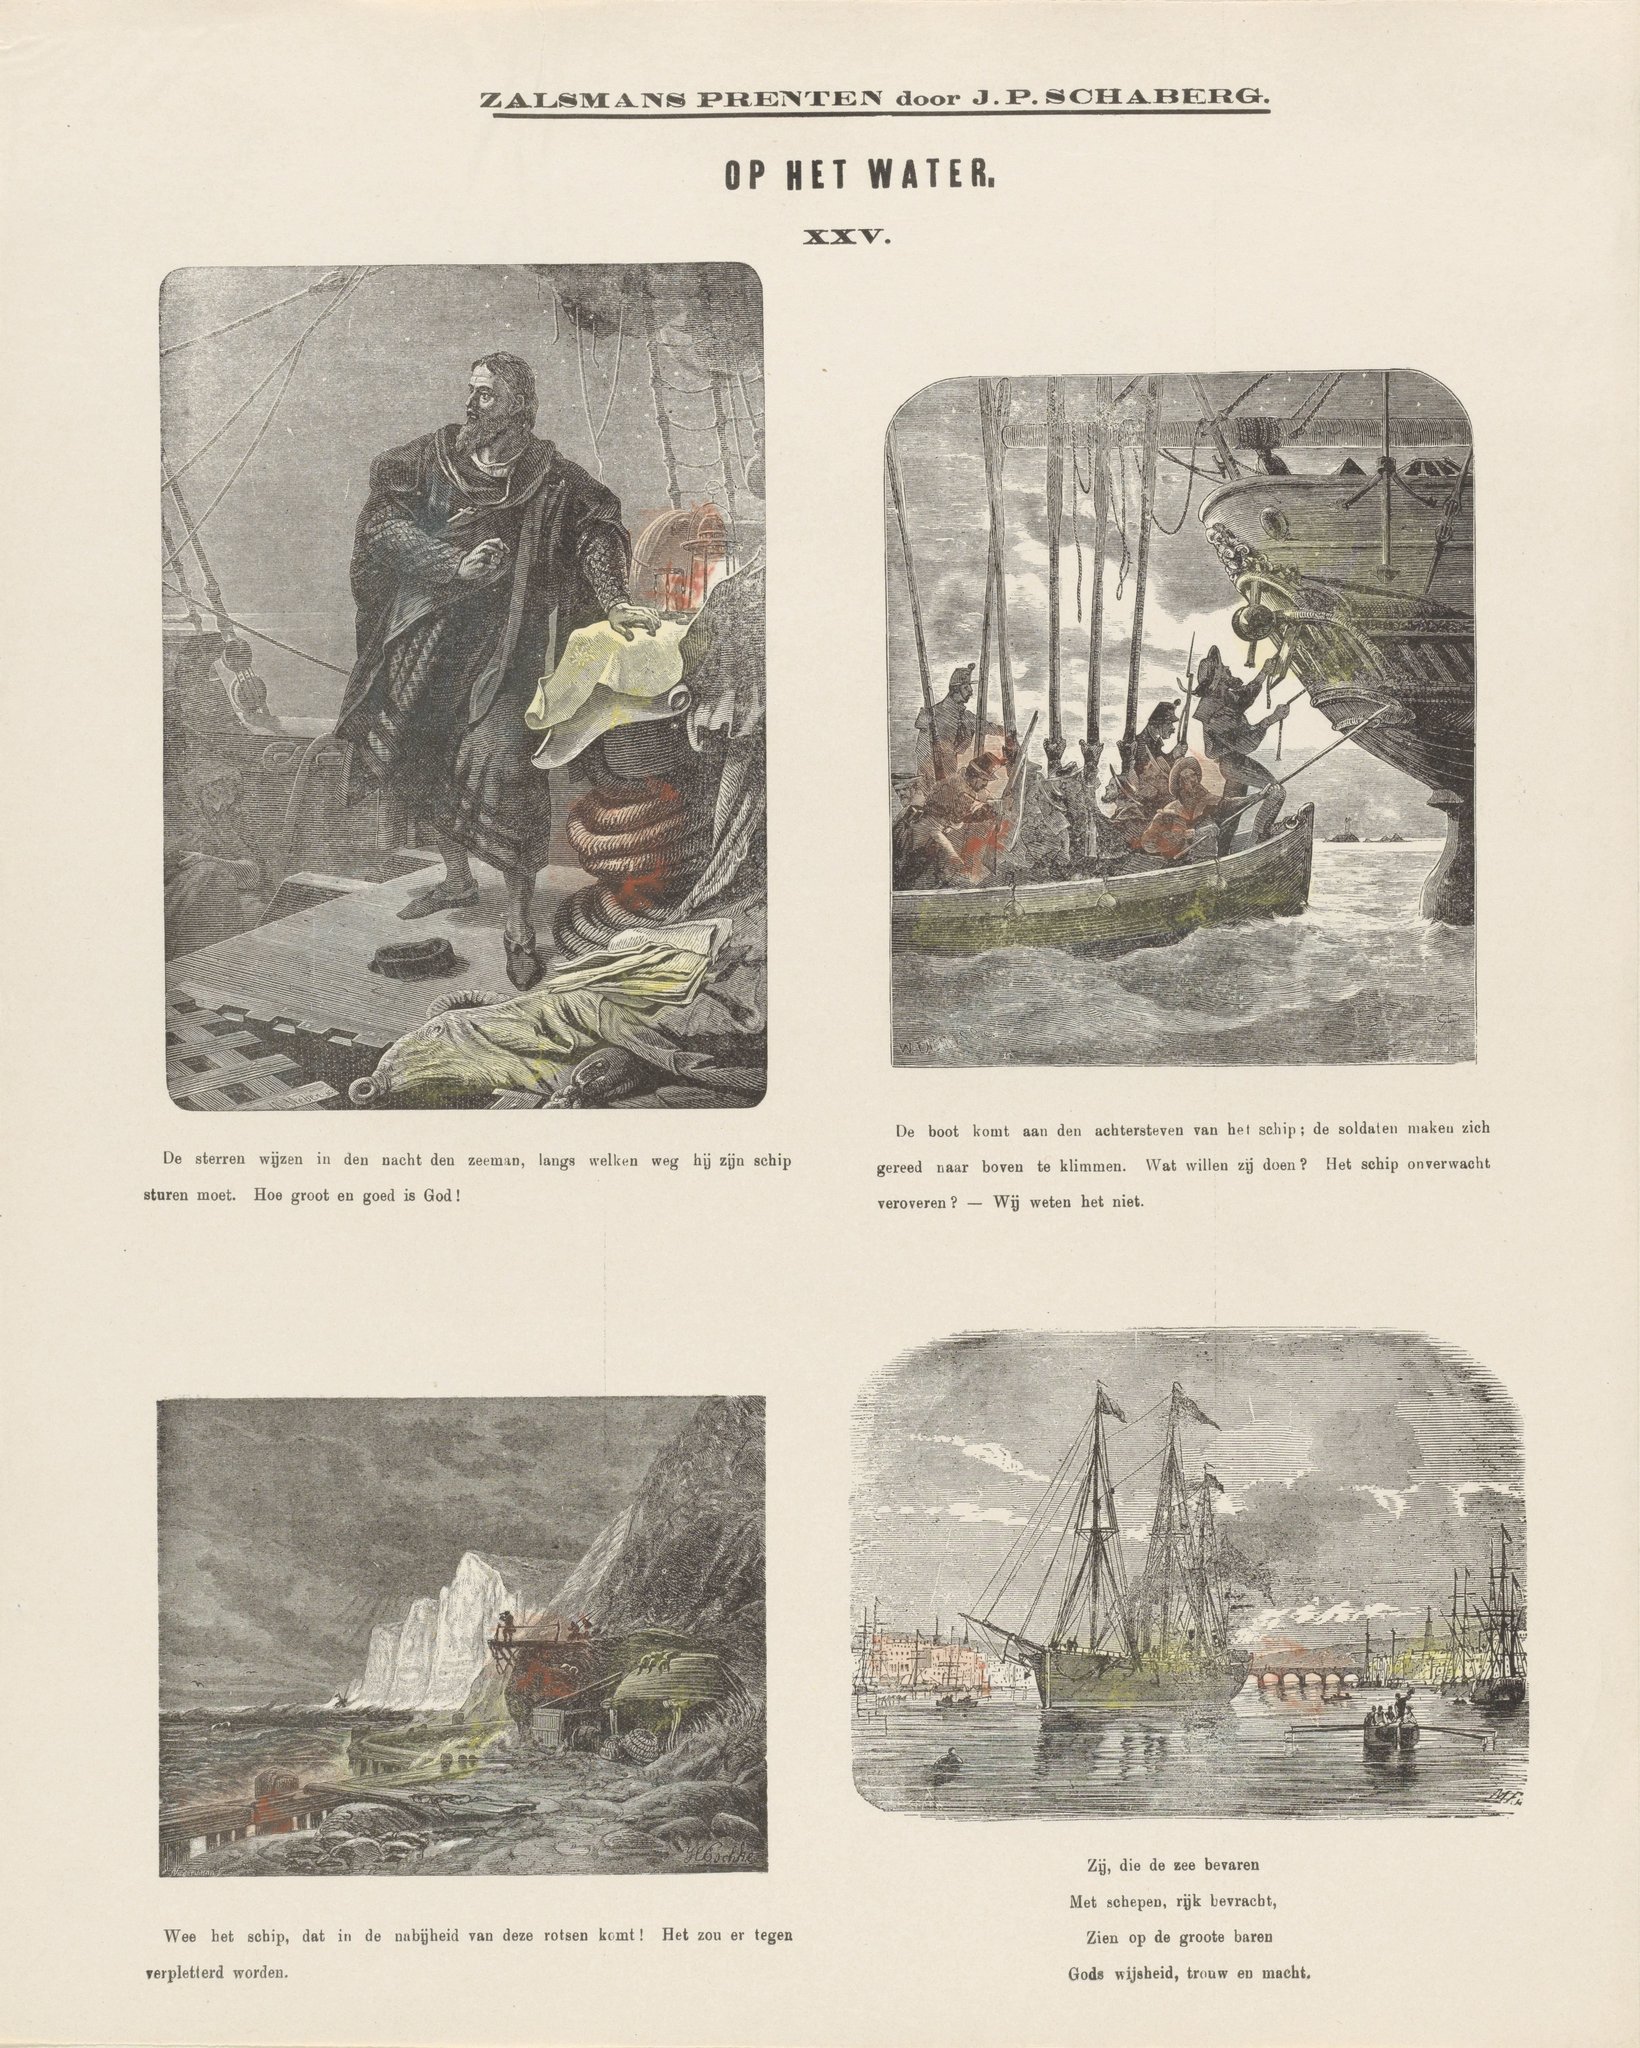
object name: print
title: Zalmans prenten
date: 1869-1882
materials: paper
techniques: colour, letterpress printing, engraving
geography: kampen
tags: ships (in general), seaman: sailor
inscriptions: collector's mark: Lugt 2760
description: Blad met 6 voorstellingen van Christoffel Columbus en schepen op zee. Onder elke afbeelding een onderschrift. Genummerd midden boven: XXV.